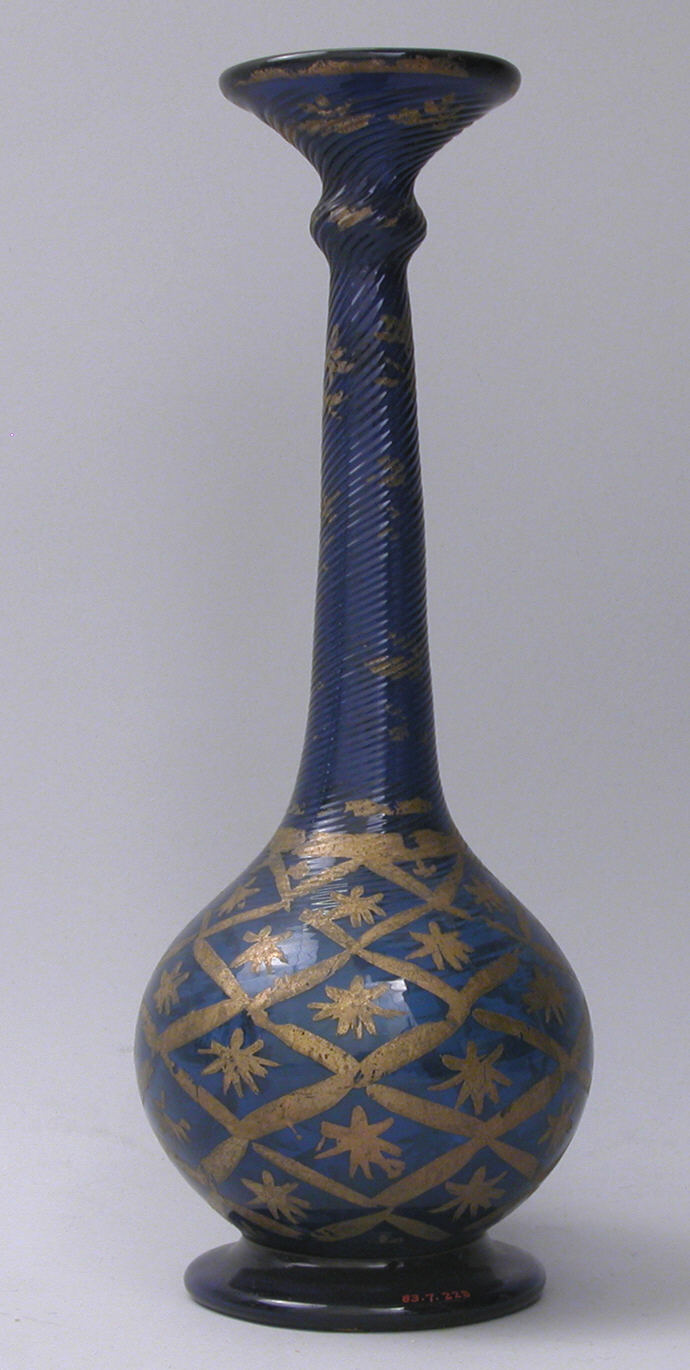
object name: bottle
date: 1701-1900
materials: glass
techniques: glassblowing, painting, tooling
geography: iran